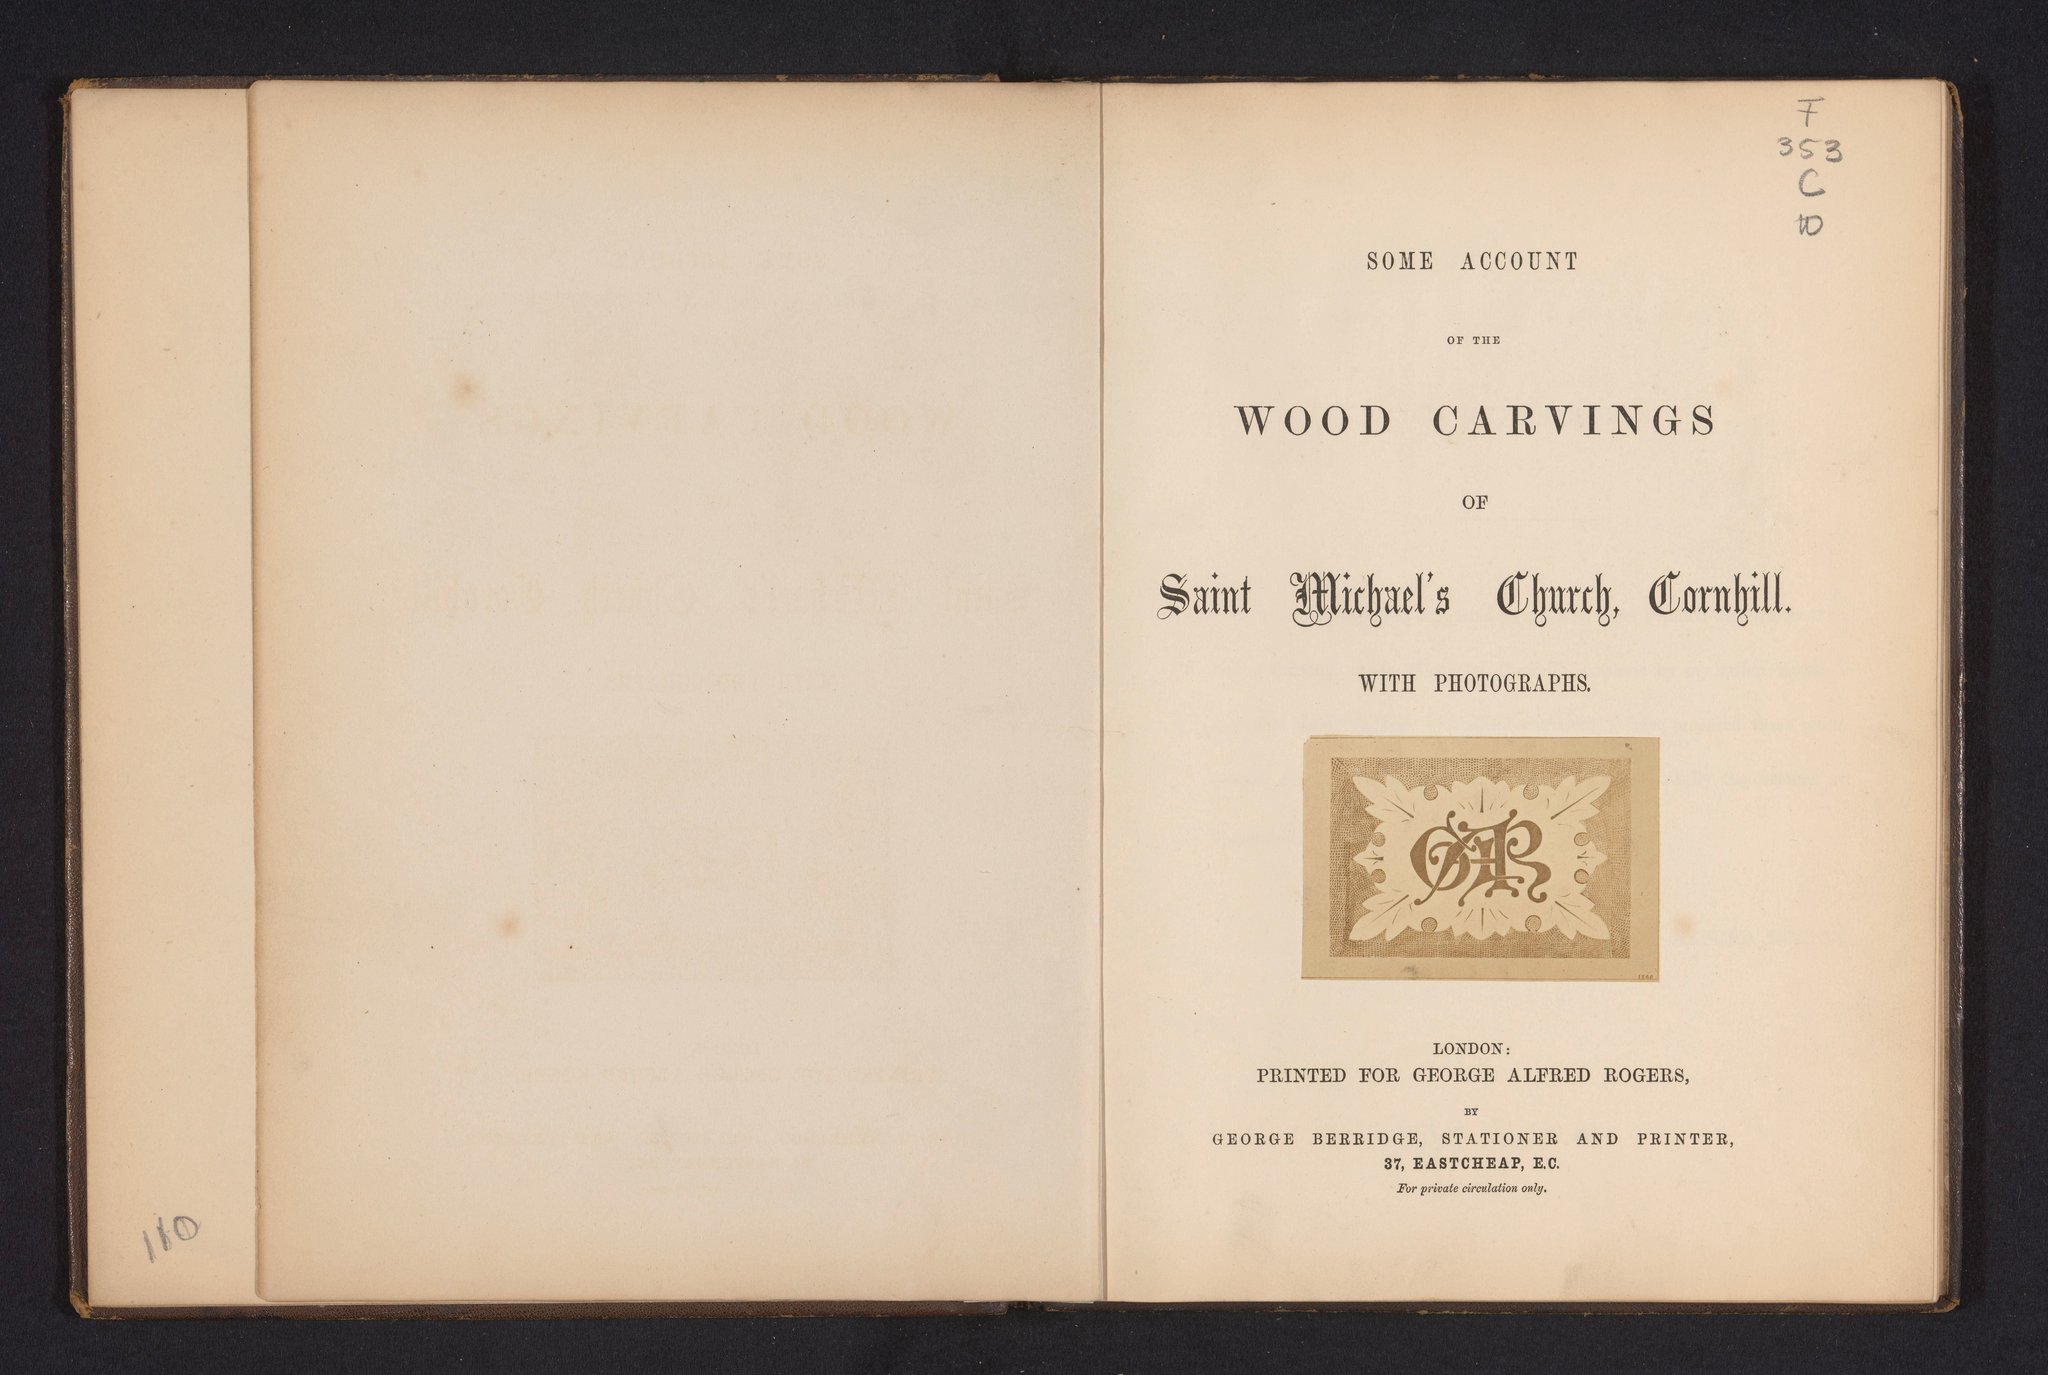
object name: page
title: Decoratie met een monogram met de initialen van George Alfred Rogers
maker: Anonymous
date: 1857-1867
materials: photographic support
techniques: albumen print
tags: flat decoration ~ applied arts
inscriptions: number: ‘1560’